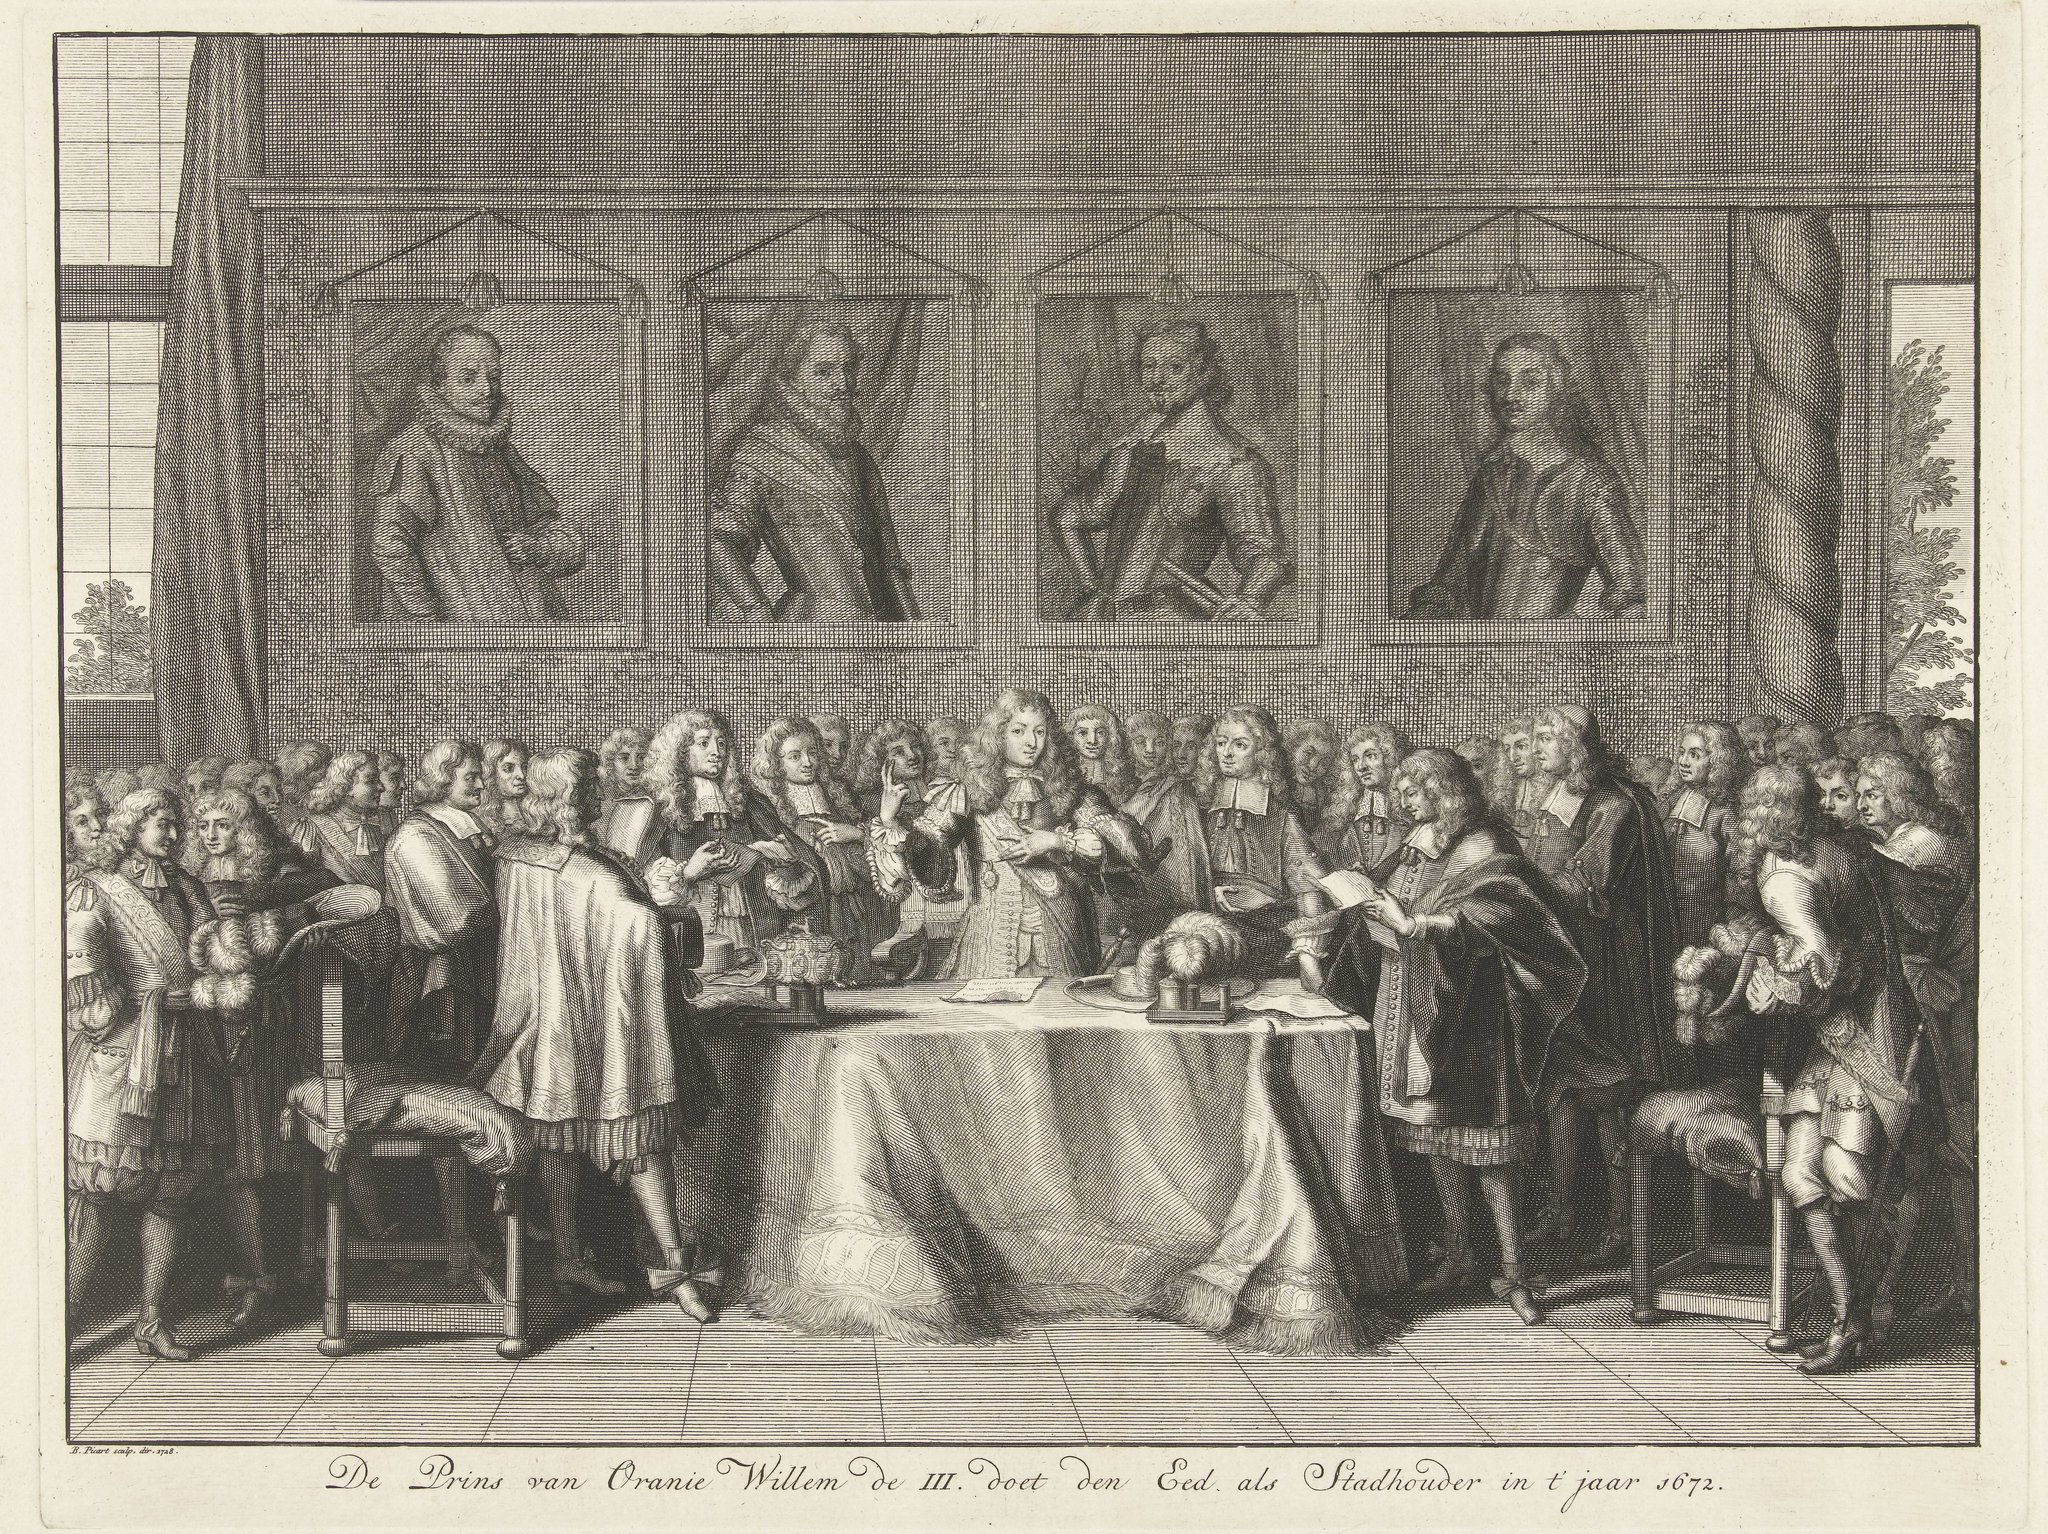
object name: history print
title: De Prins van Oranie Willem de III. doet den Eed als Stadhouder in 't jaar 1672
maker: bernard picart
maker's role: draughtsman, print maker, publisher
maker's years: 1673-1733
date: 1728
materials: paper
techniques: engraving, etching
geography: northern netherlands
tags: william iii (prince of orange and king of england, scotland, and ireland), the hague, frederick henry (prince of orange), william ii (prince of orange), delft, william i (prince of orange), maurice (prince of orange), new ruler taking the oath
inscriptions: date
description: Gebruikt als illustratie in: J. le Clerc, Geschiedenissen der Vereenigde Nederlanden, sedert den aanvang van die Republyk tot op den Vrede van Utrecht in 't jaar 1713 en het Tractaat van Barriere in 't jaar 1715 gesloten, Z. Chatelain, Amsterdam 1730, 3 delen, dl. III, p. 410.